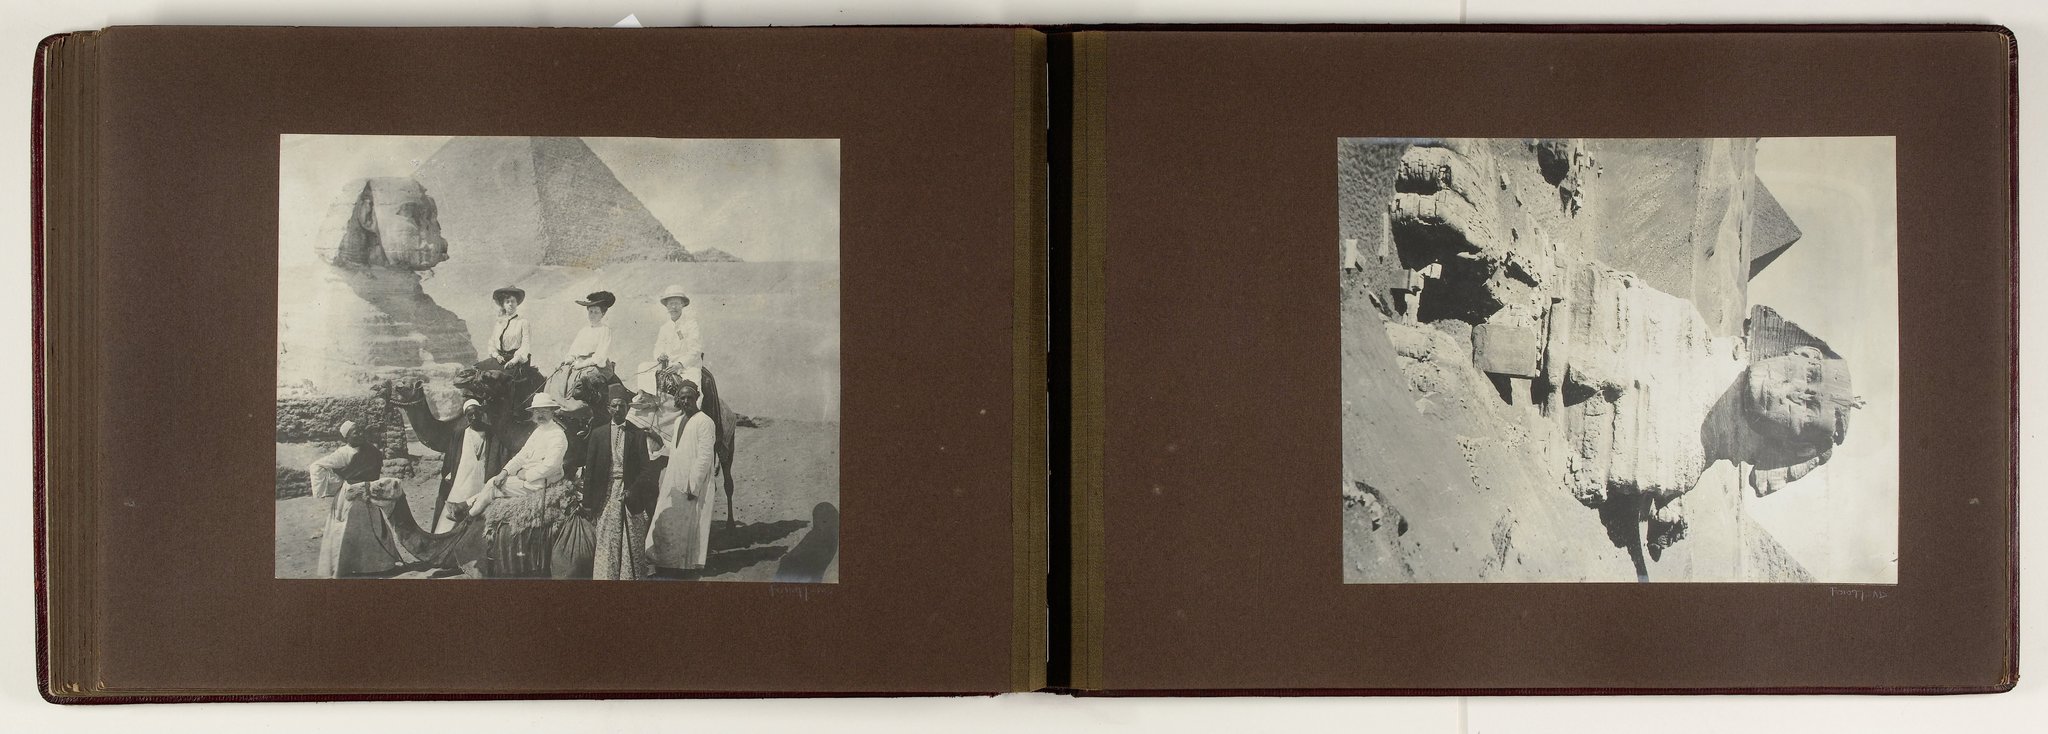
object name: photograph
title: Vier Europese toeristen op kamelen met Egyptische gidsen bij de piramide en sfinx van Gizeh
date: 1880-1900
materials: paper, photographic support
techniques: gelatin silver print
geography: gizeh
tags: sphinx (lion/woman); 'sfinge' (ripa), hoofed animals, guide (~ conducted tour), travelling; tourism, pyramid (historical grave form)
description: Onderdeel van Reisalbum met foto's van Duitsland, Zwitserland, het Suezkanaal en Nederlands-Indië.